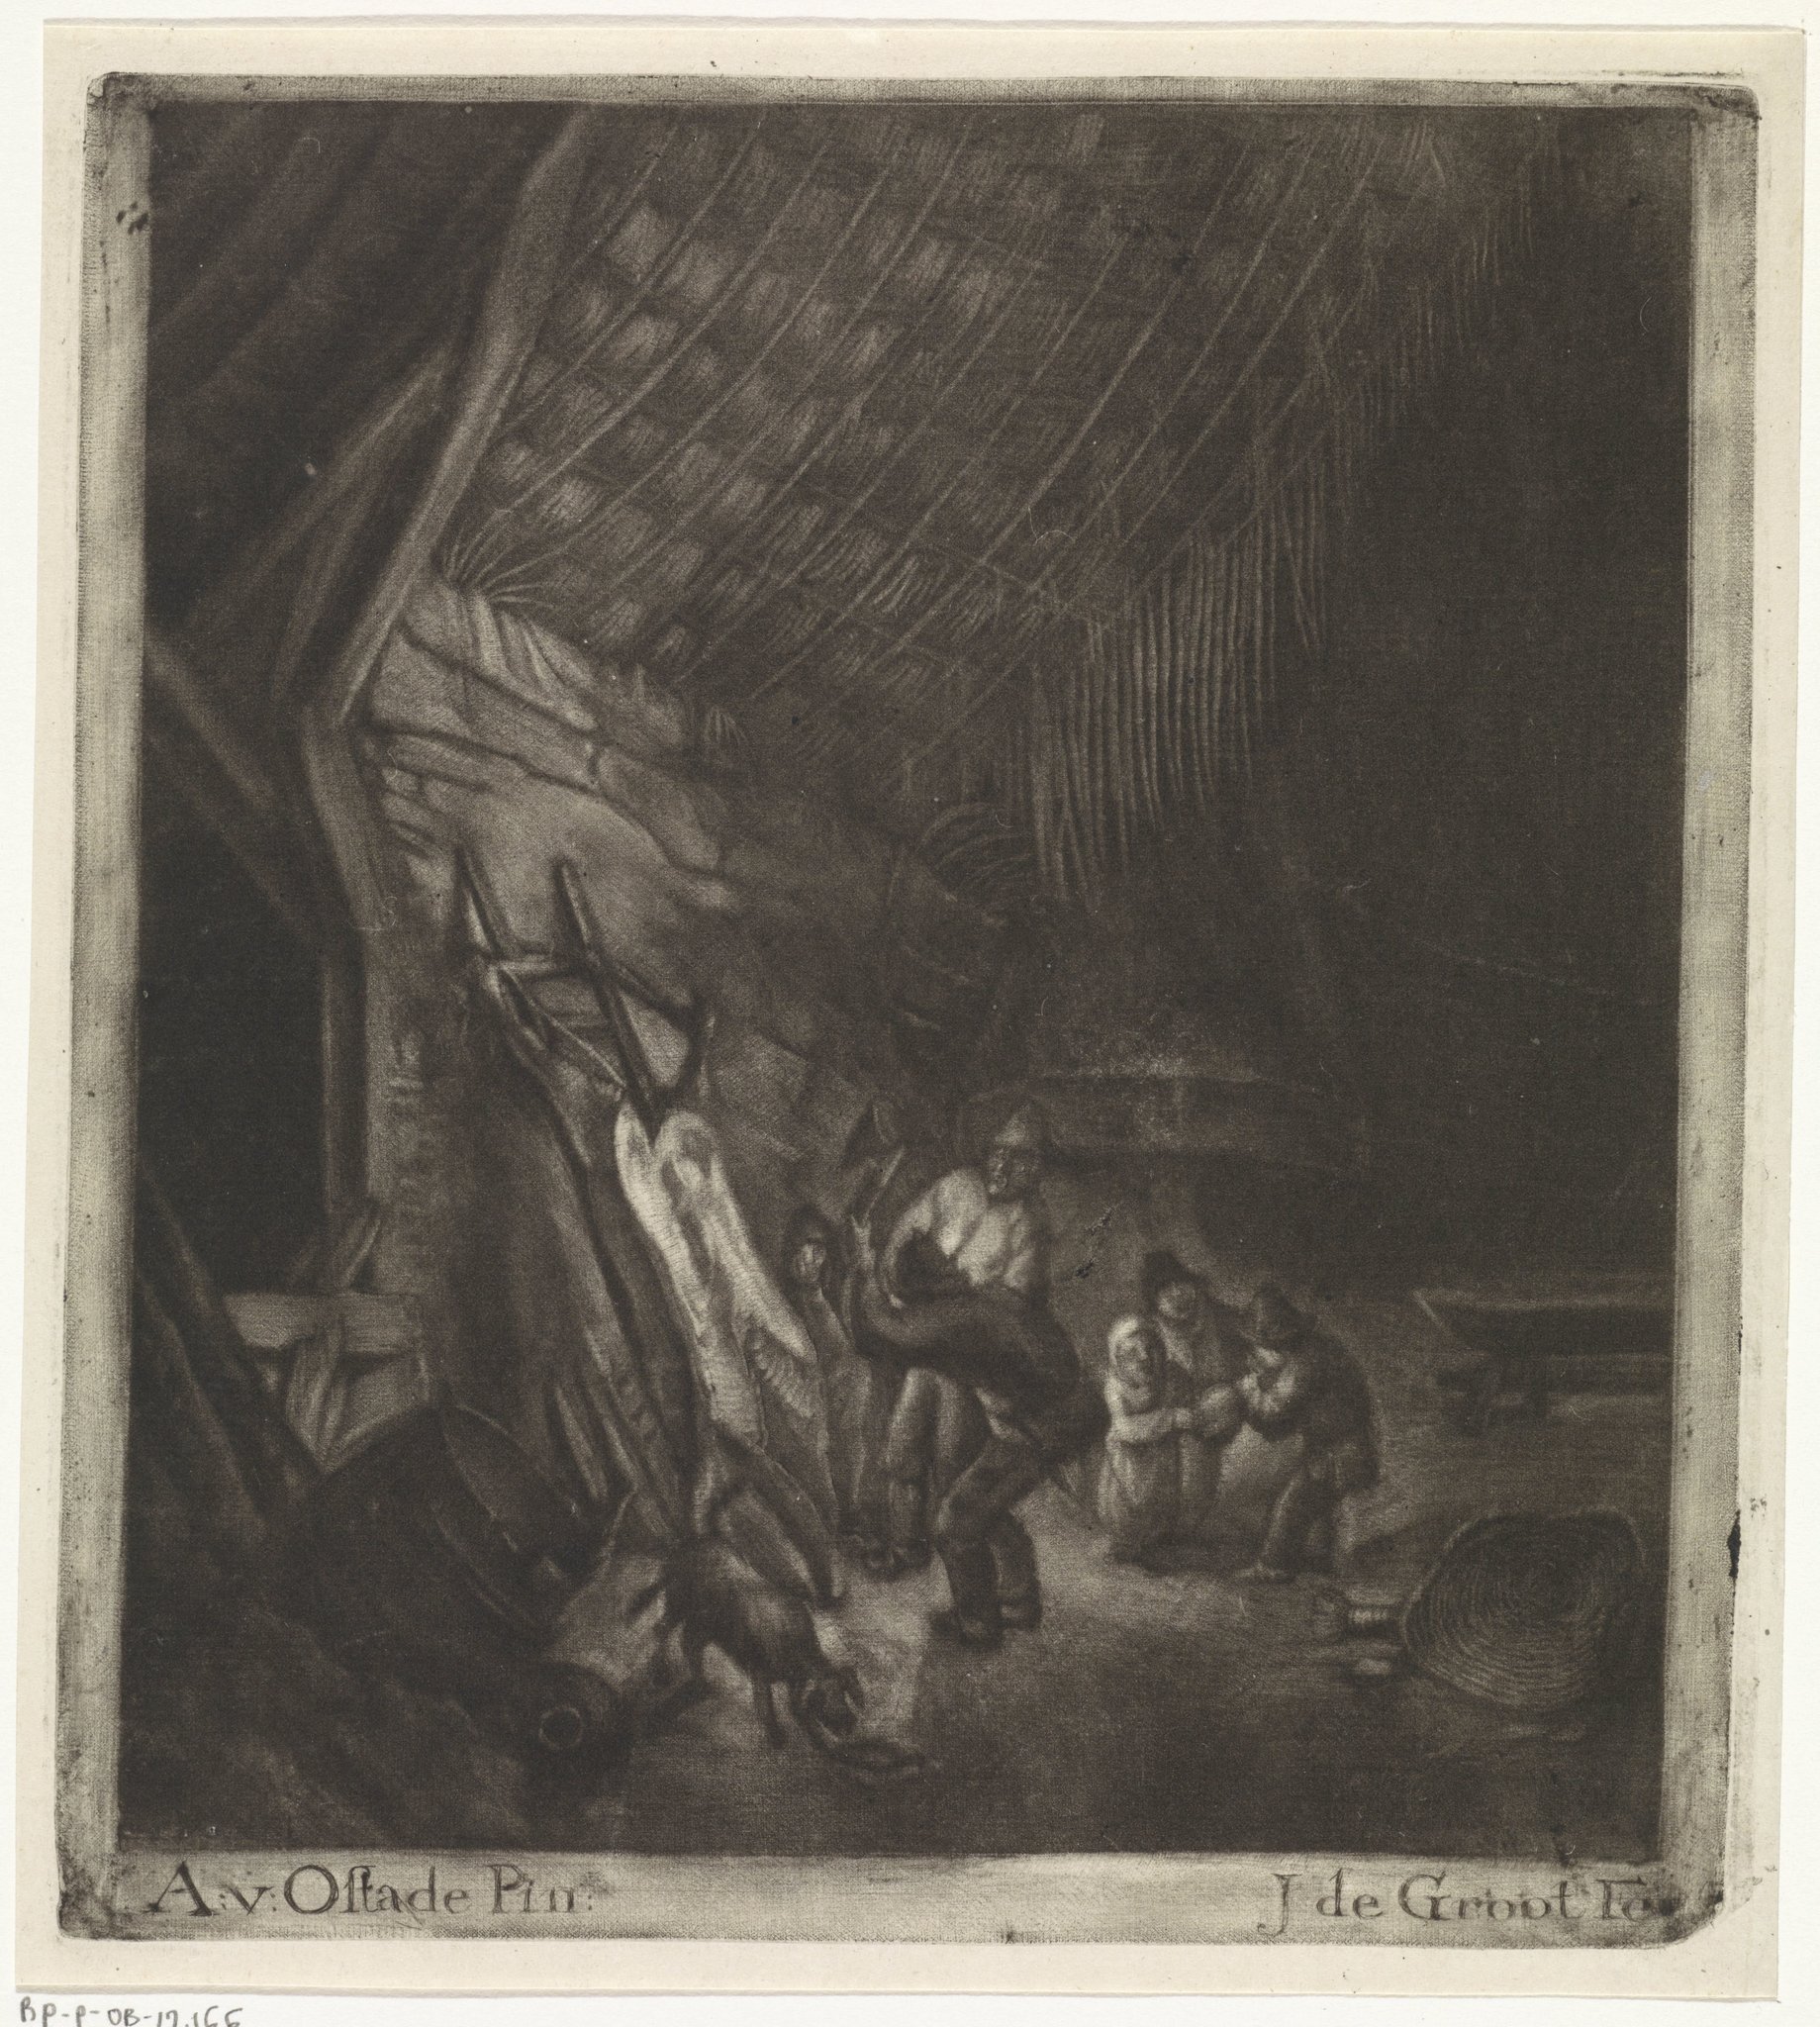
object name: print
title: Het slachten van een varken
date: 1698-1776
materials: paper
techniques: engraving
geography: northern netherlands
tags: butcher, slaughterman, shed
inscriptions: collector's mark: Lugt 240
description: In een schuur beent een man een varken uit. Twee figuren kijken toe. Op de achtergrond spelen drie kinderen met een varkensblaas.